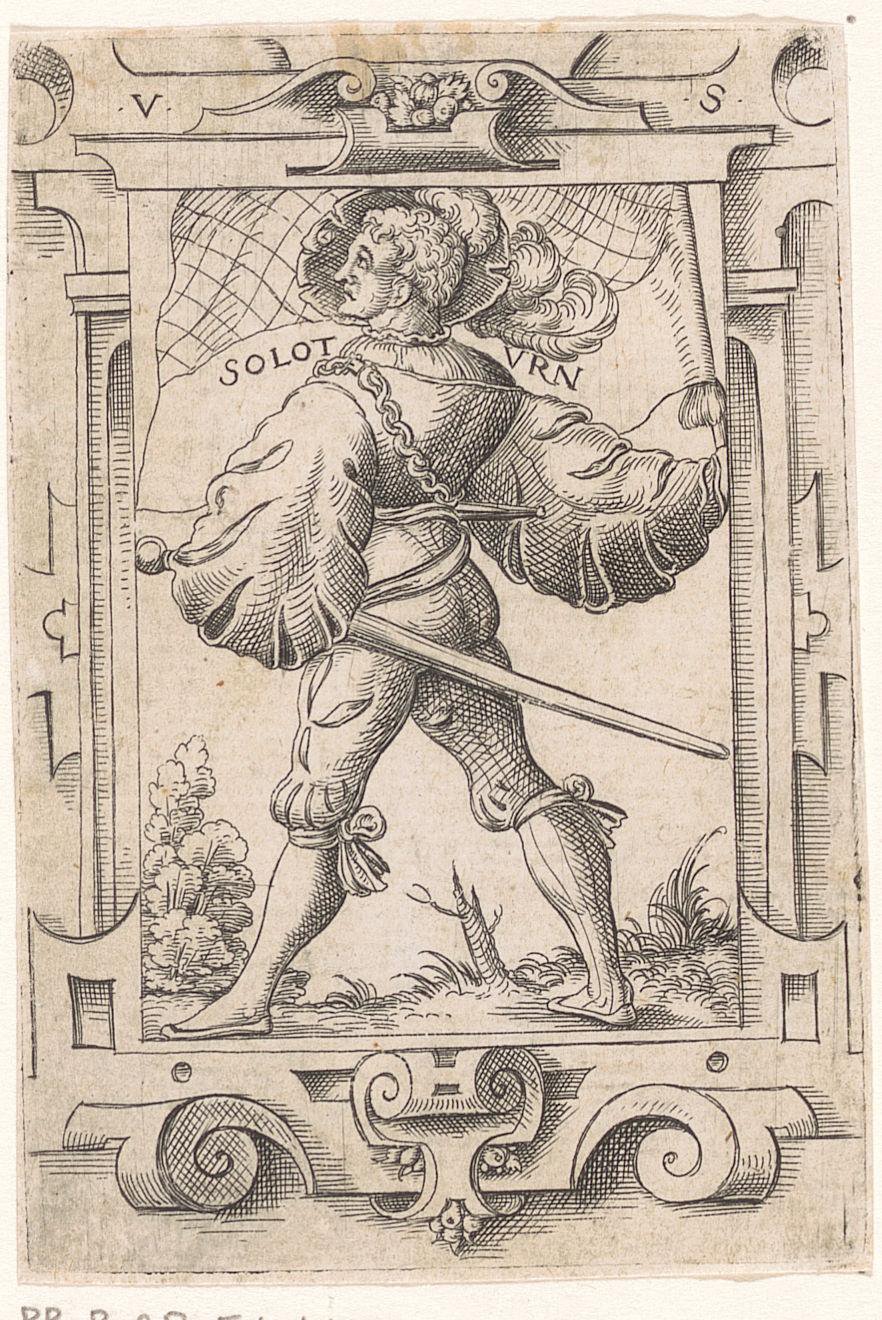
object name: print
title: Vaandeldrager met vaandel van Solothurn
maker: virgilius solis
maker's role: draughtsman, print maker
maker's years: 1514-1562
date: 1524-1562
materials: paper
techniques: engraving, etching, intaglio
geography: nuremberg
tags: scrollwork, strapwork ~ ornament, (military) standard-bearer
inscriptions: collector's mark: Lugt 2228, number: ‘145’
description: Prent maakt deel uit van een serie van veertien prenten met voorstellingen van vaandeldragers met vaandels van de Zwitserse kantons.